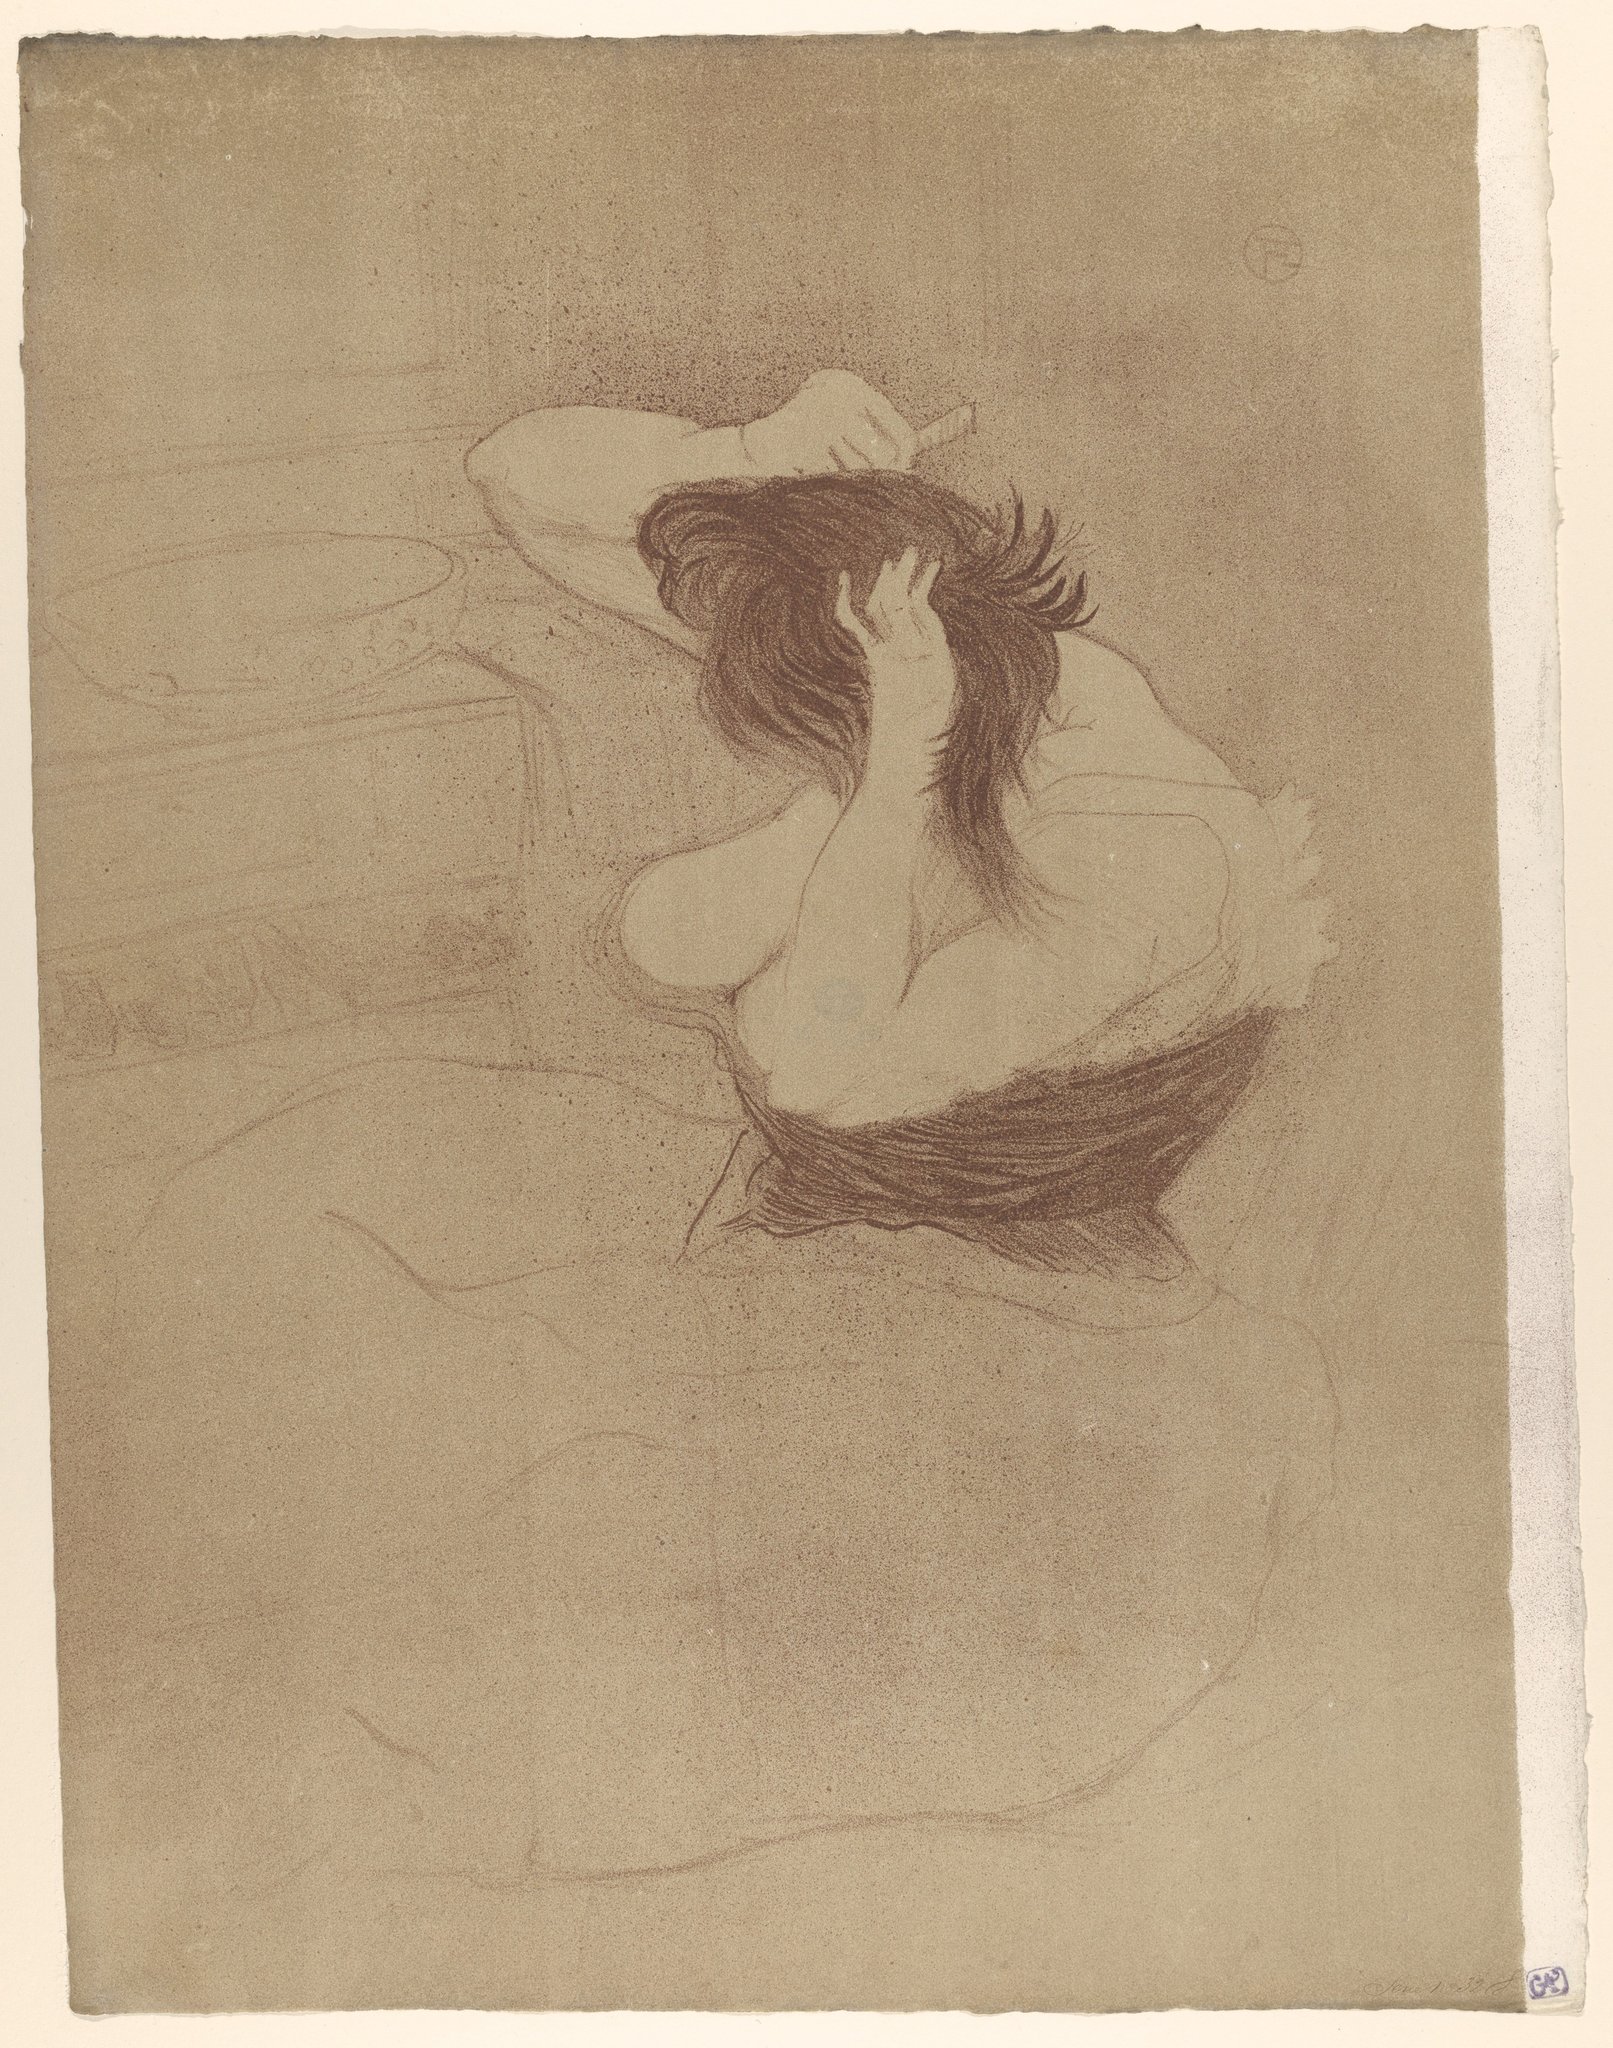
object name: print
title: Combing Hair, from "Elles"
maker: henri de toulouse-lautrec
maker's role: artist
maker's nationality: french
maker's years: 1864-1901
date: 1896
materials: crayon, paper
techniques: brush, lithograph, printing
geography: france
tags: hair,women